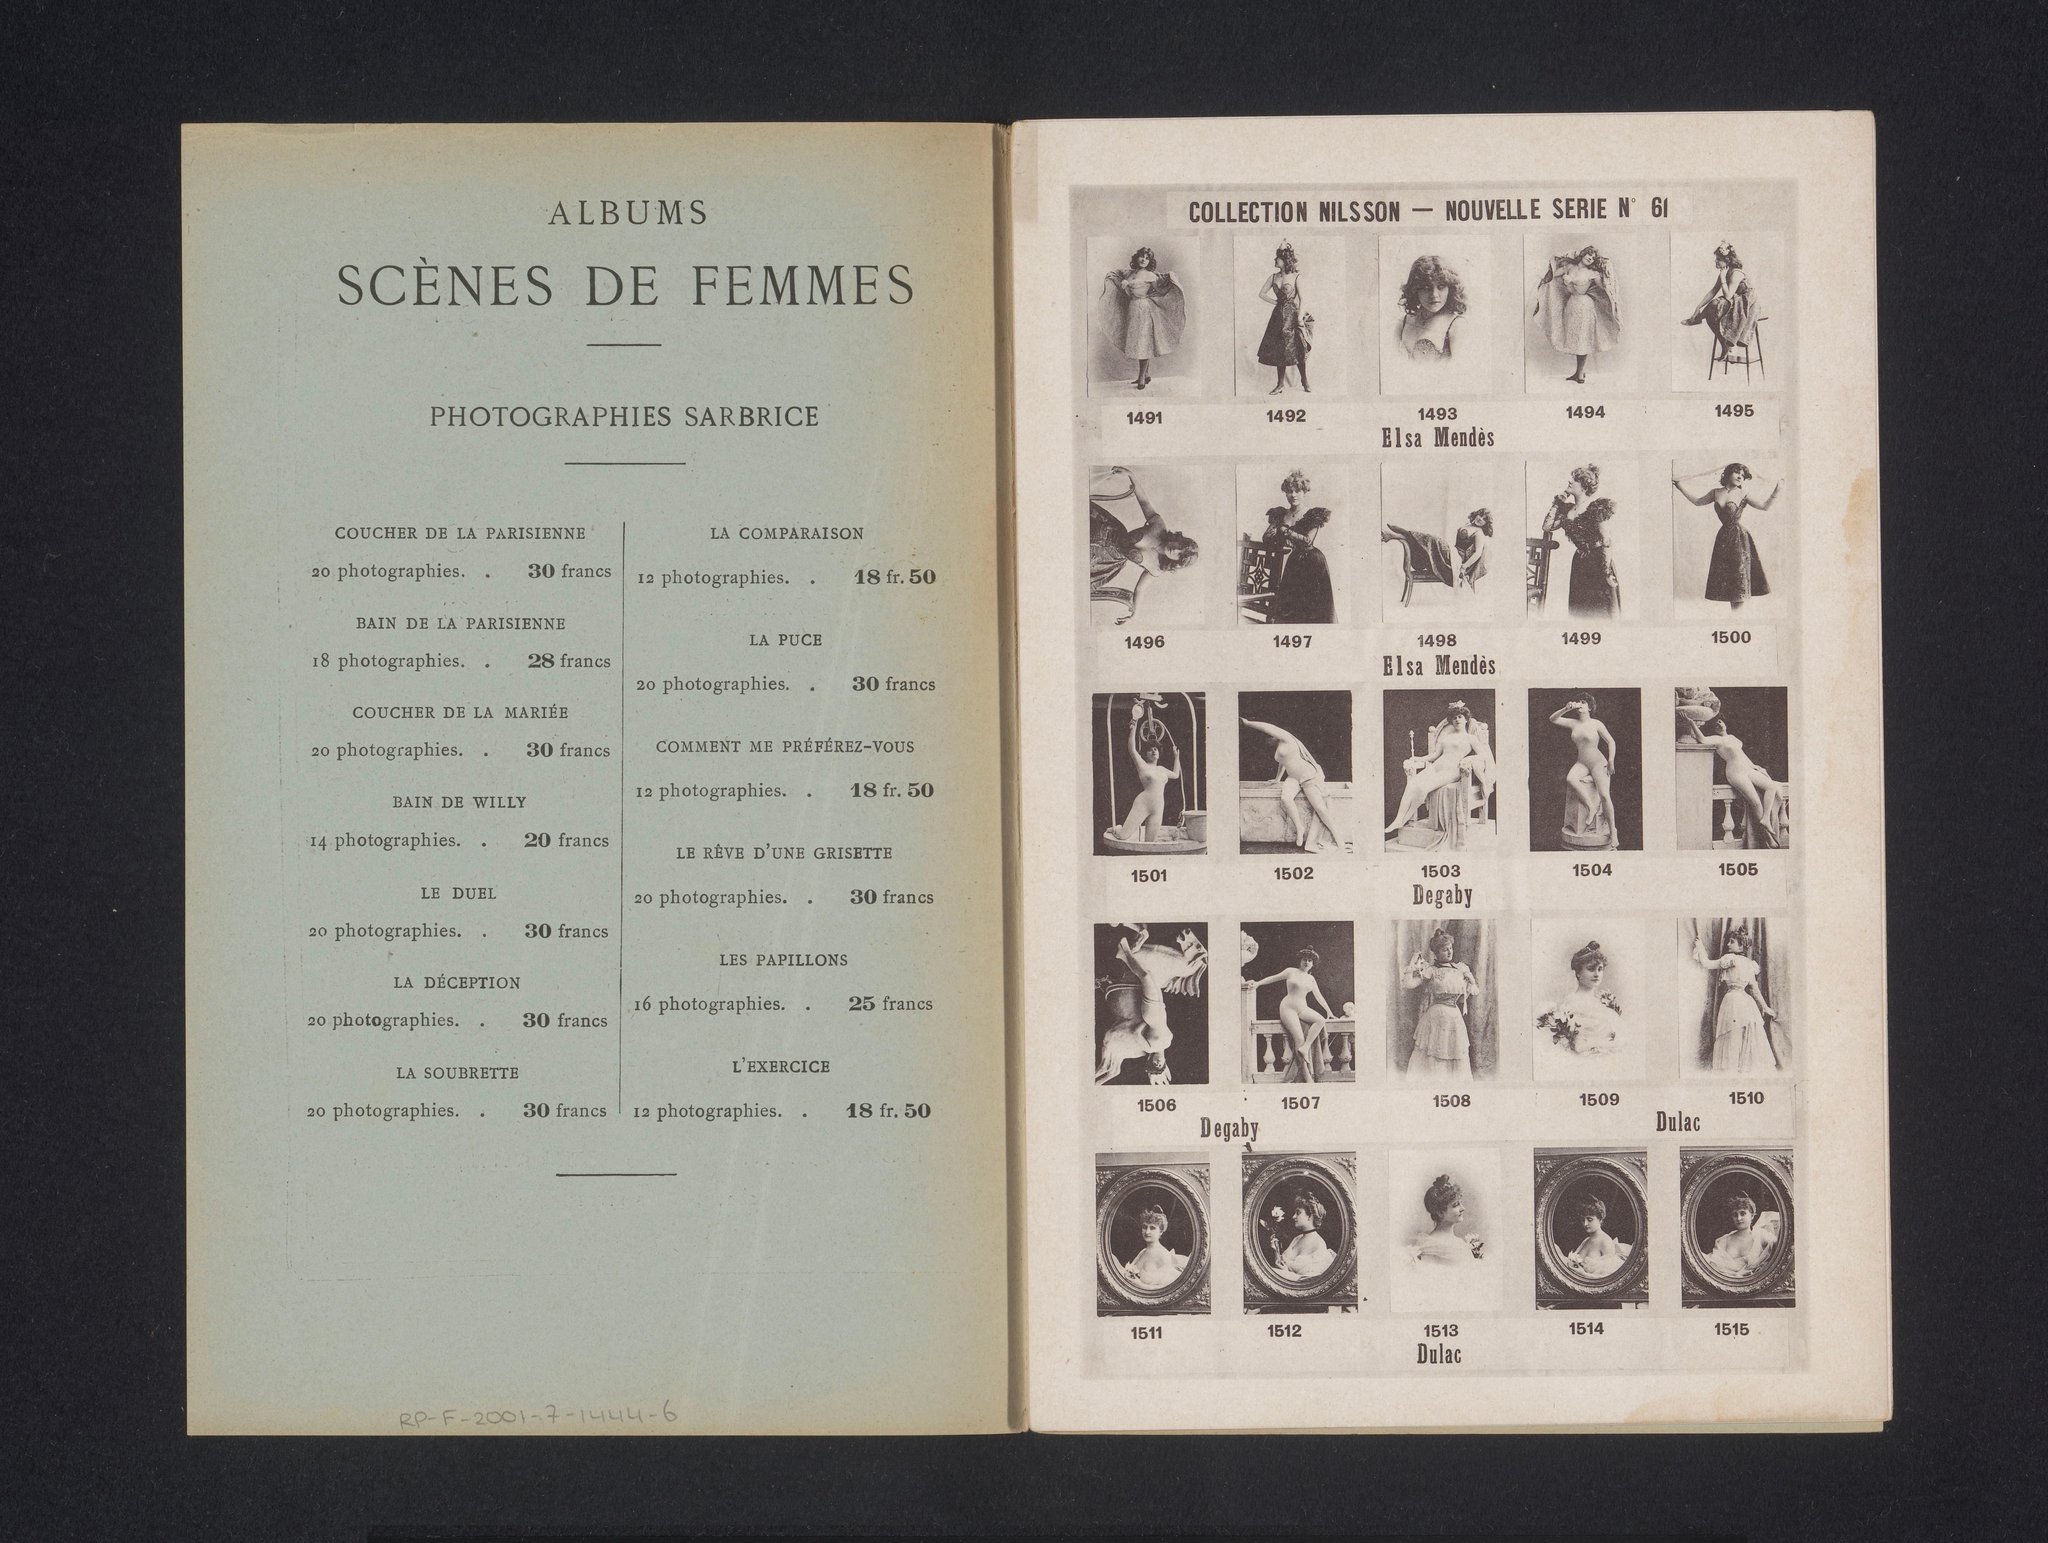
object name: page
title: 25 portretten van Elsa Mendès, Degaby en Dulac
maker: Anonymous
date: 1892-1897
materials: paper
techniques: photograph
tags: historical persons - bb - woman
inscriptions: number: ‘No 61’